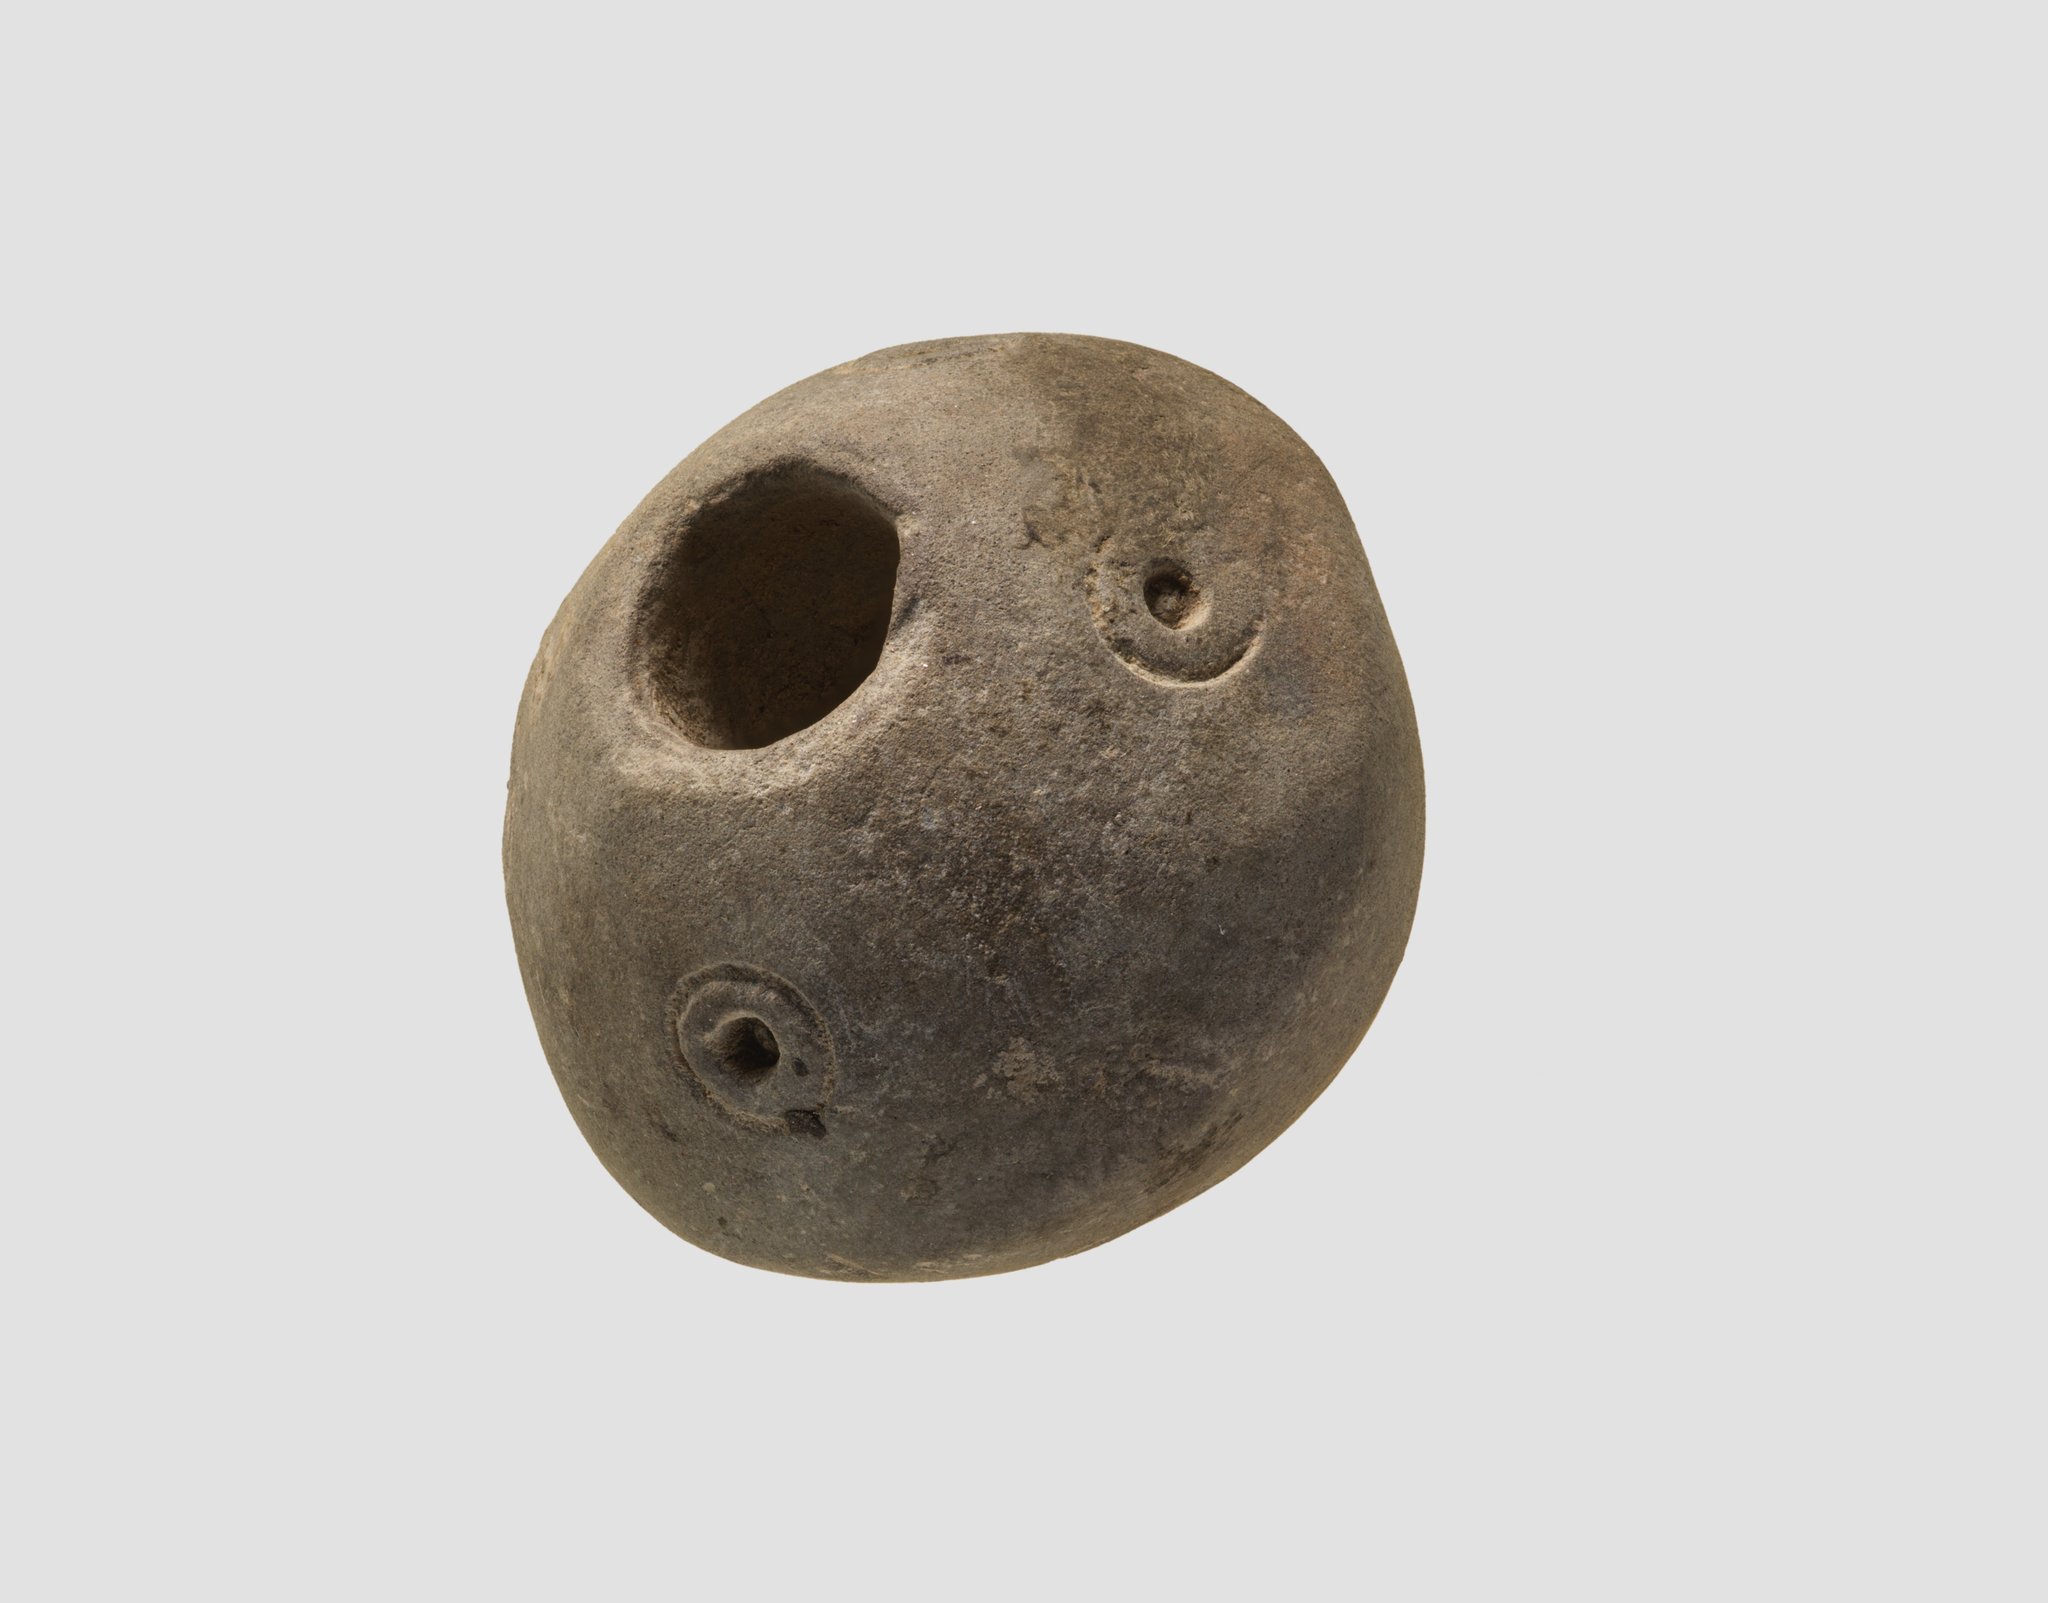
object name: whorl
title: Spindle whorl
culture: iranian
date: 700 BCE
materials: ceramic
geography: iran